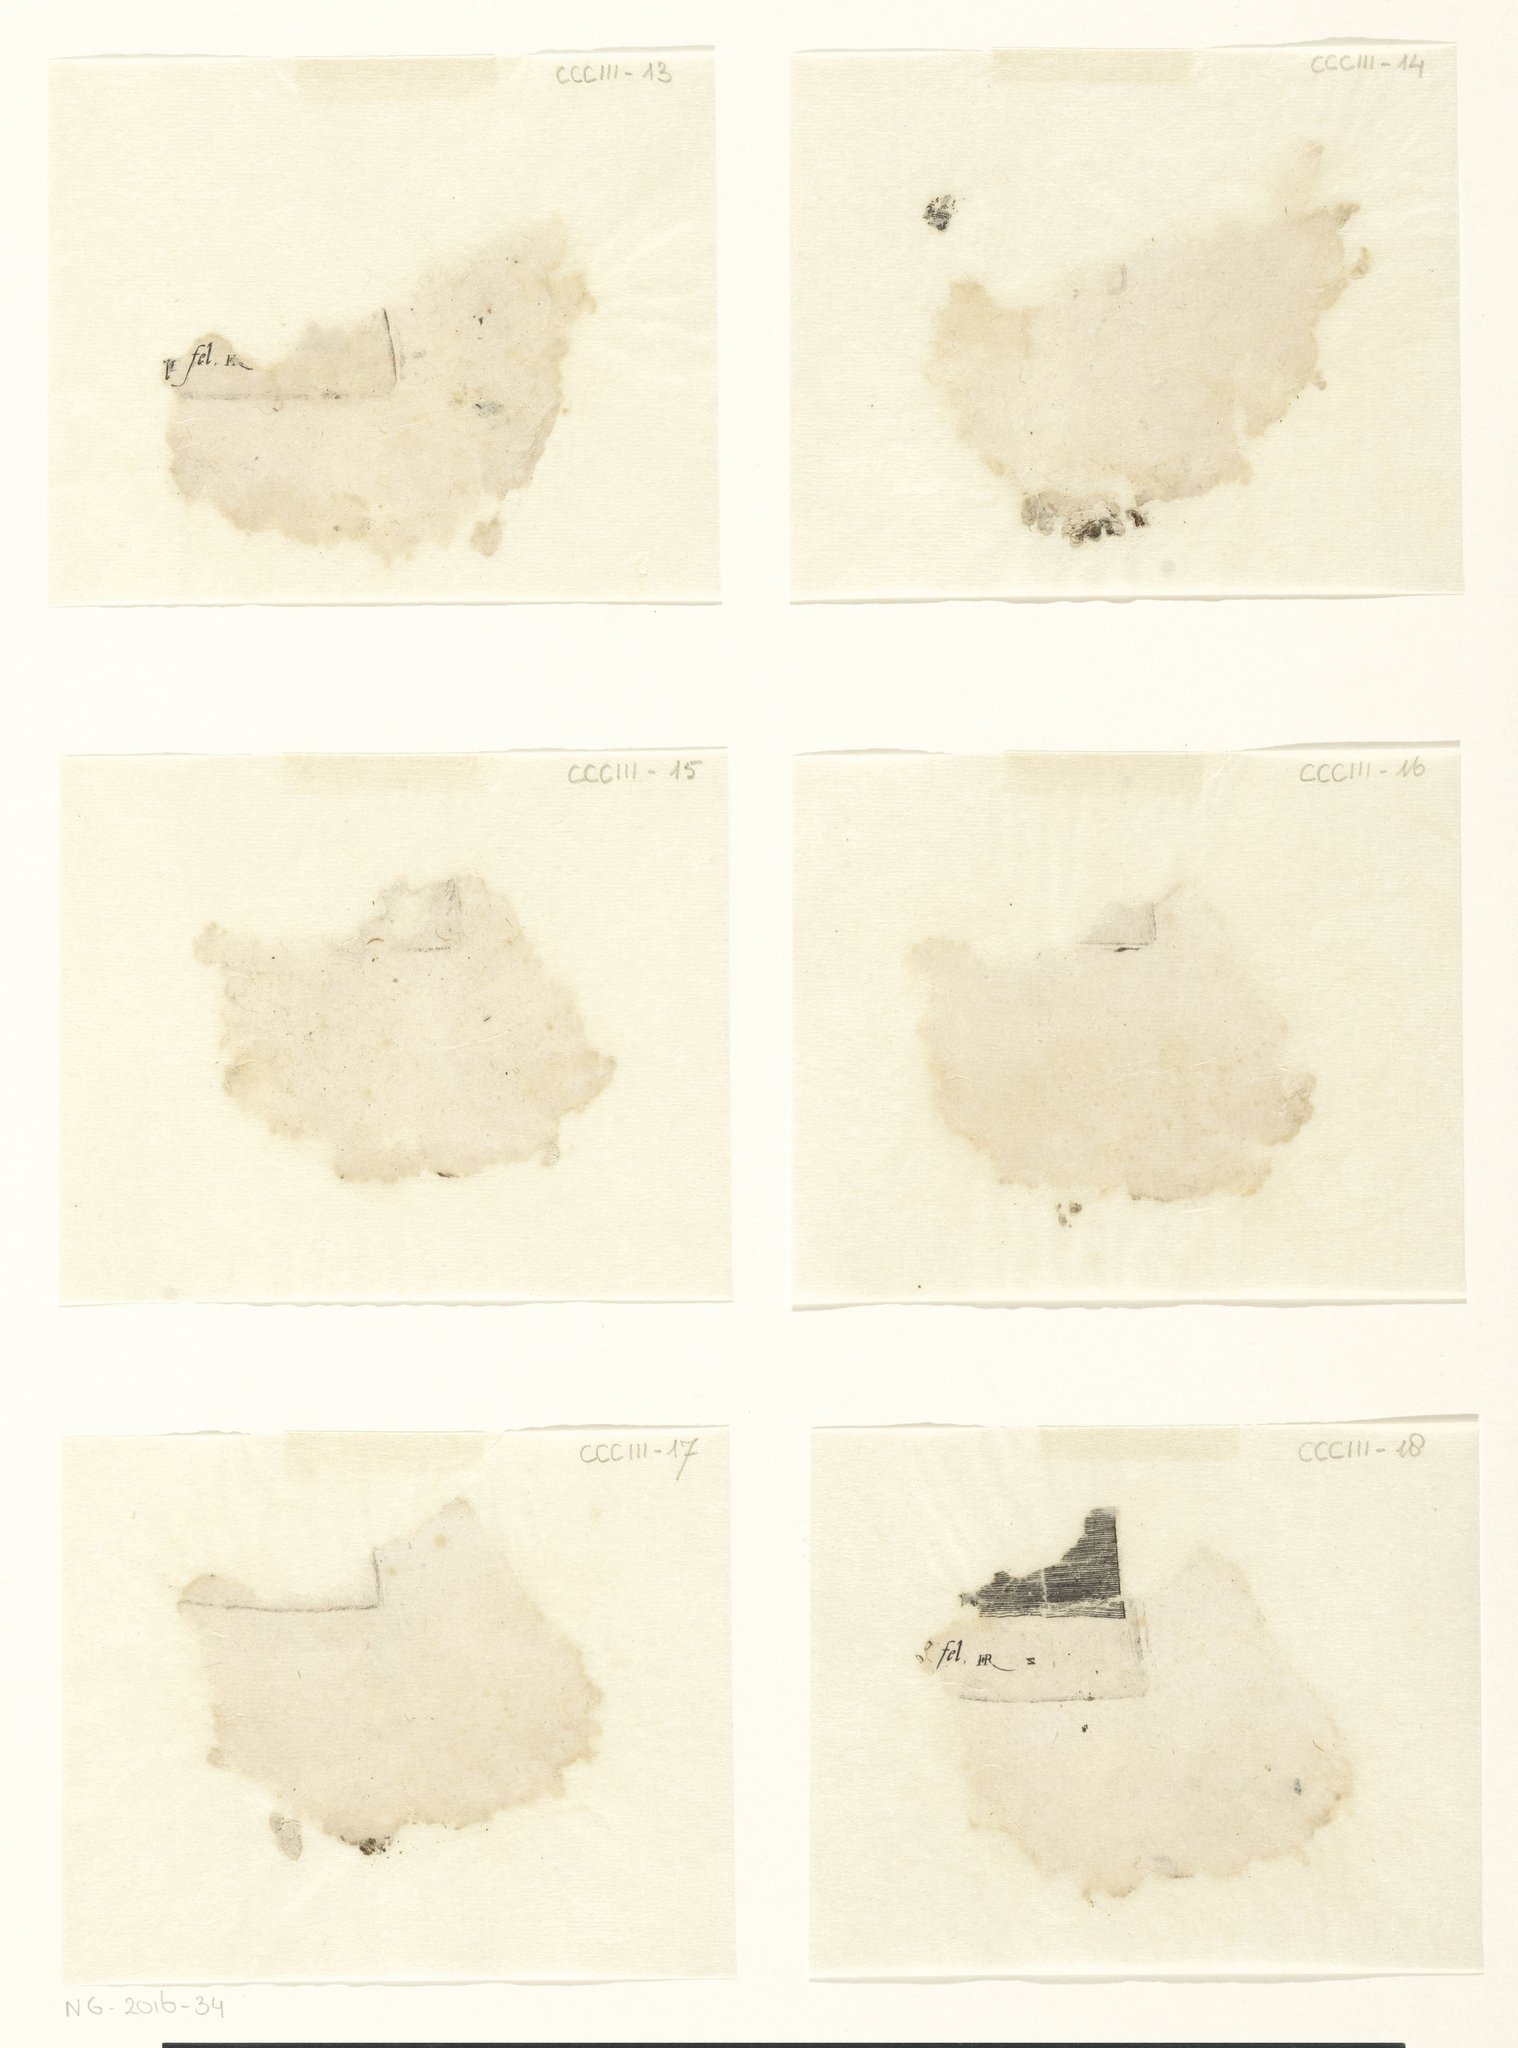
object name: print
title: Losse fragmenten, vermoedelijk van prenten van de geschiedenis van Tobias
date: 1580-1596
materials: paper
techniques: engraving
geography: amsterdam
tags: story of tobias: tobias' return (tobit 10-13), story of tobias: tobias and sarah (tobit 7-9), the journey to ecbatana (tobit 4-6)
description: De prenten in de Nova Zembla collectie zijn tijdens een expeditie van Willem Barendsz en Jacob van Heemskerk in 1596-1597 noodgedwongen in het winterkamp, het ‘Behouden Huis’, op het eiland achtergelaten. De prenten waren in één of meerdere stapels als handelswaar meegenomen vanuit Amsterdam. Bijna drie eeuwen later, in 1871, keerde de Noor Elling Carlsen terug naar Nova Zembla en vond daar de restanten van het ‘Behouden Huis, inclusief een groot deel van de inventaris. Een deel van de prenten, in de vorm van aaneengekoekte kluiten, werd toen ook teruggevonden. De papierkluiten waren soms op meerdere plekken gebroken. Tussen 1975-1979 zijn de prenten van elkaar gescheiden. Dit leverde in totaal ca. 1000 fragmenten van ca. 400 afdrukken van ca. 150 verschillende prenten op. Voor zover mogelijk zijn de fragmenten samengevoegd en zijn de prenten gereconstrueerd.